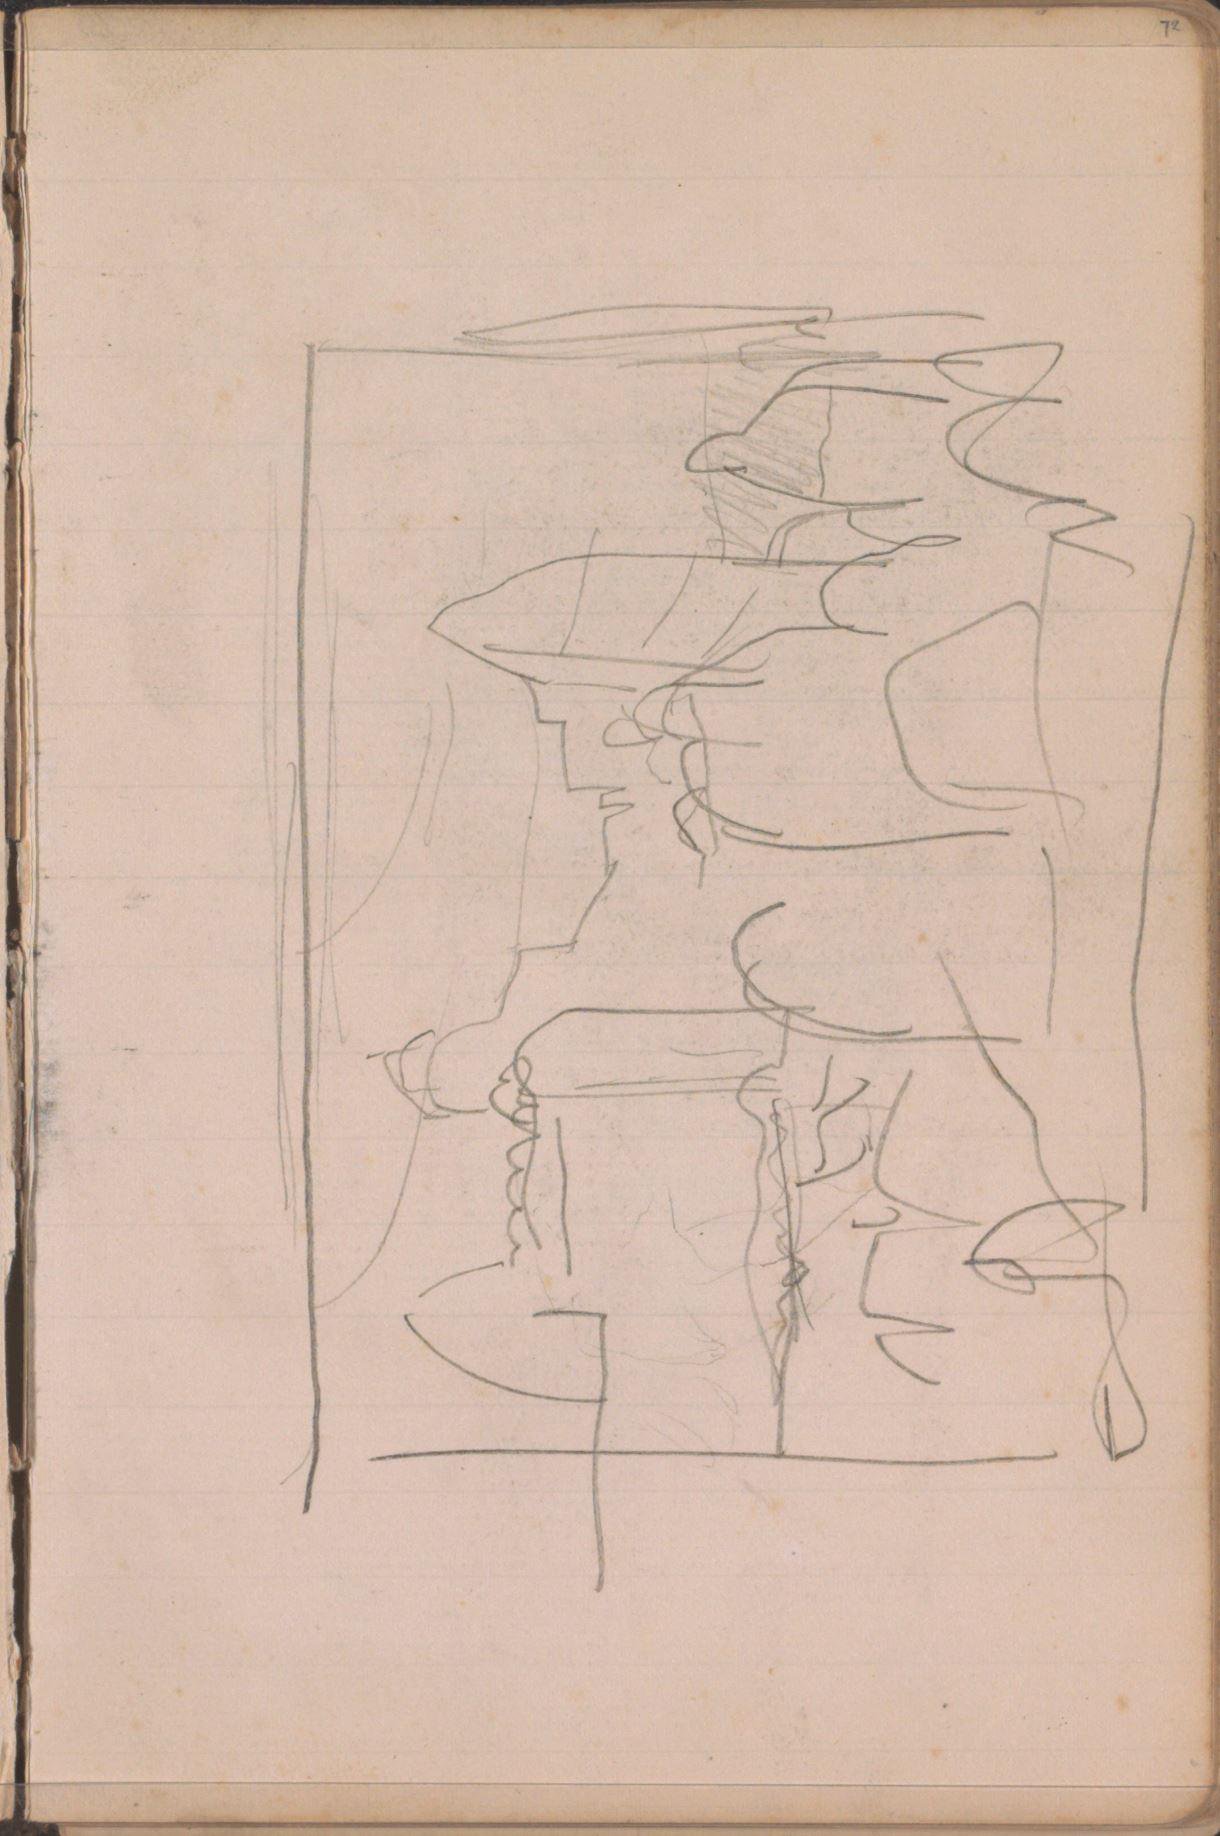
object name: sketchbook leaf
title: Straat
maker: marius bauer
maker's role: draughtsman, print maker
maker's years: 1867-1932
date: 1897-1898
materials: pencil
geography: india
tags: street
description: Pagina 72 uit een schetsboek met 84 bladen.